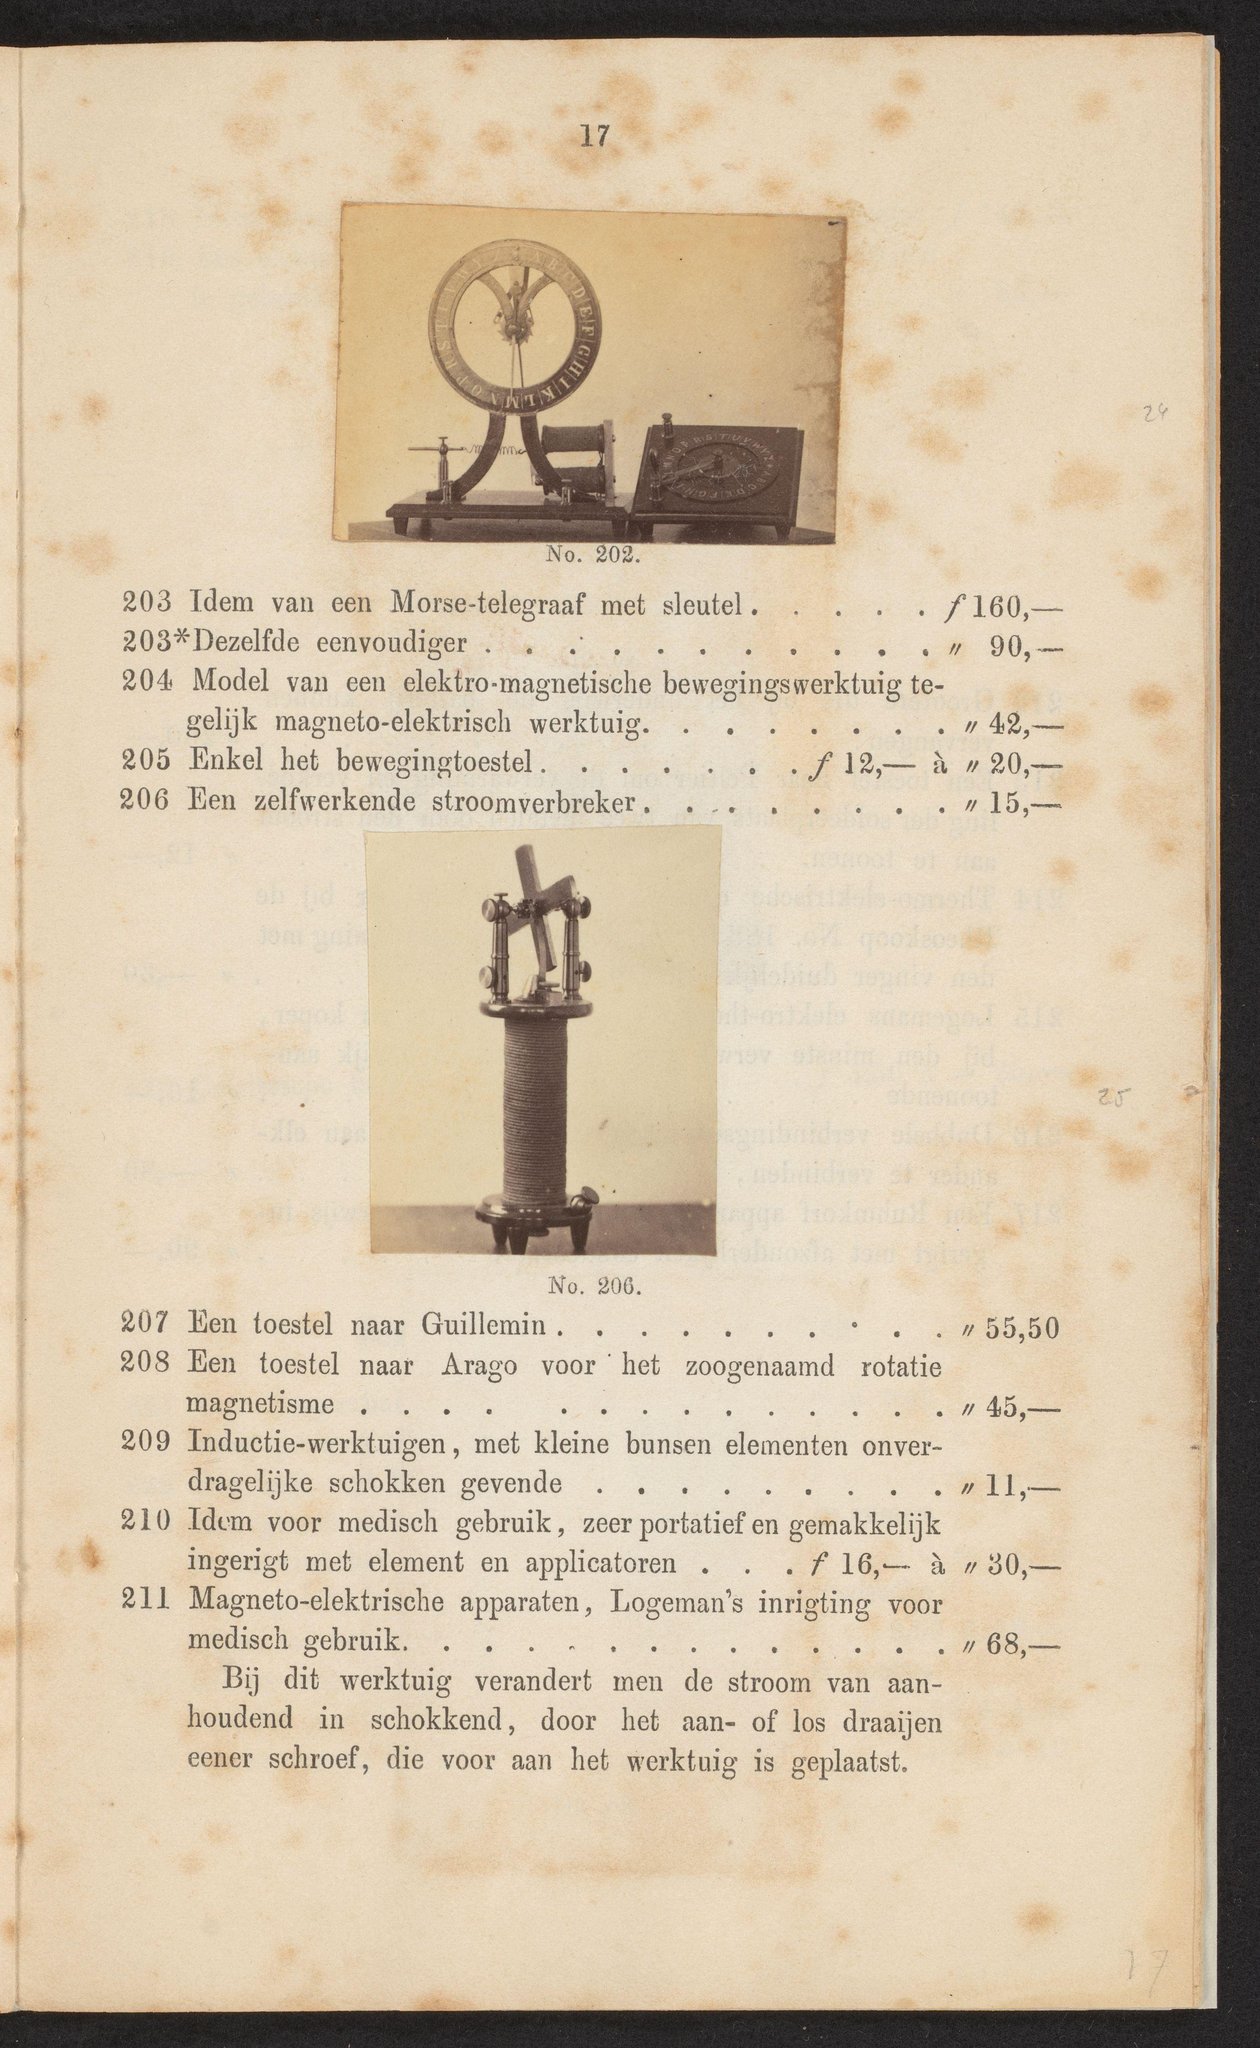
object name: page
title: Twee natuurkundige instrumenten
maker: fredrich wilhelm funckler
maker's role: instrument maker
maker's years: 1836-1886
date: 1857-1867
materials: paper, photographic support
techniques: albumen print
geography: netherlands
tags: physics (+ tools, instruments; laboratory equipment ~ scientific research)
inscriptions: number: ‘No. 202., No. 206.’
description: Boven een model van een wijzertelegraaf, onder een zelfwerkende stroomverbreker.